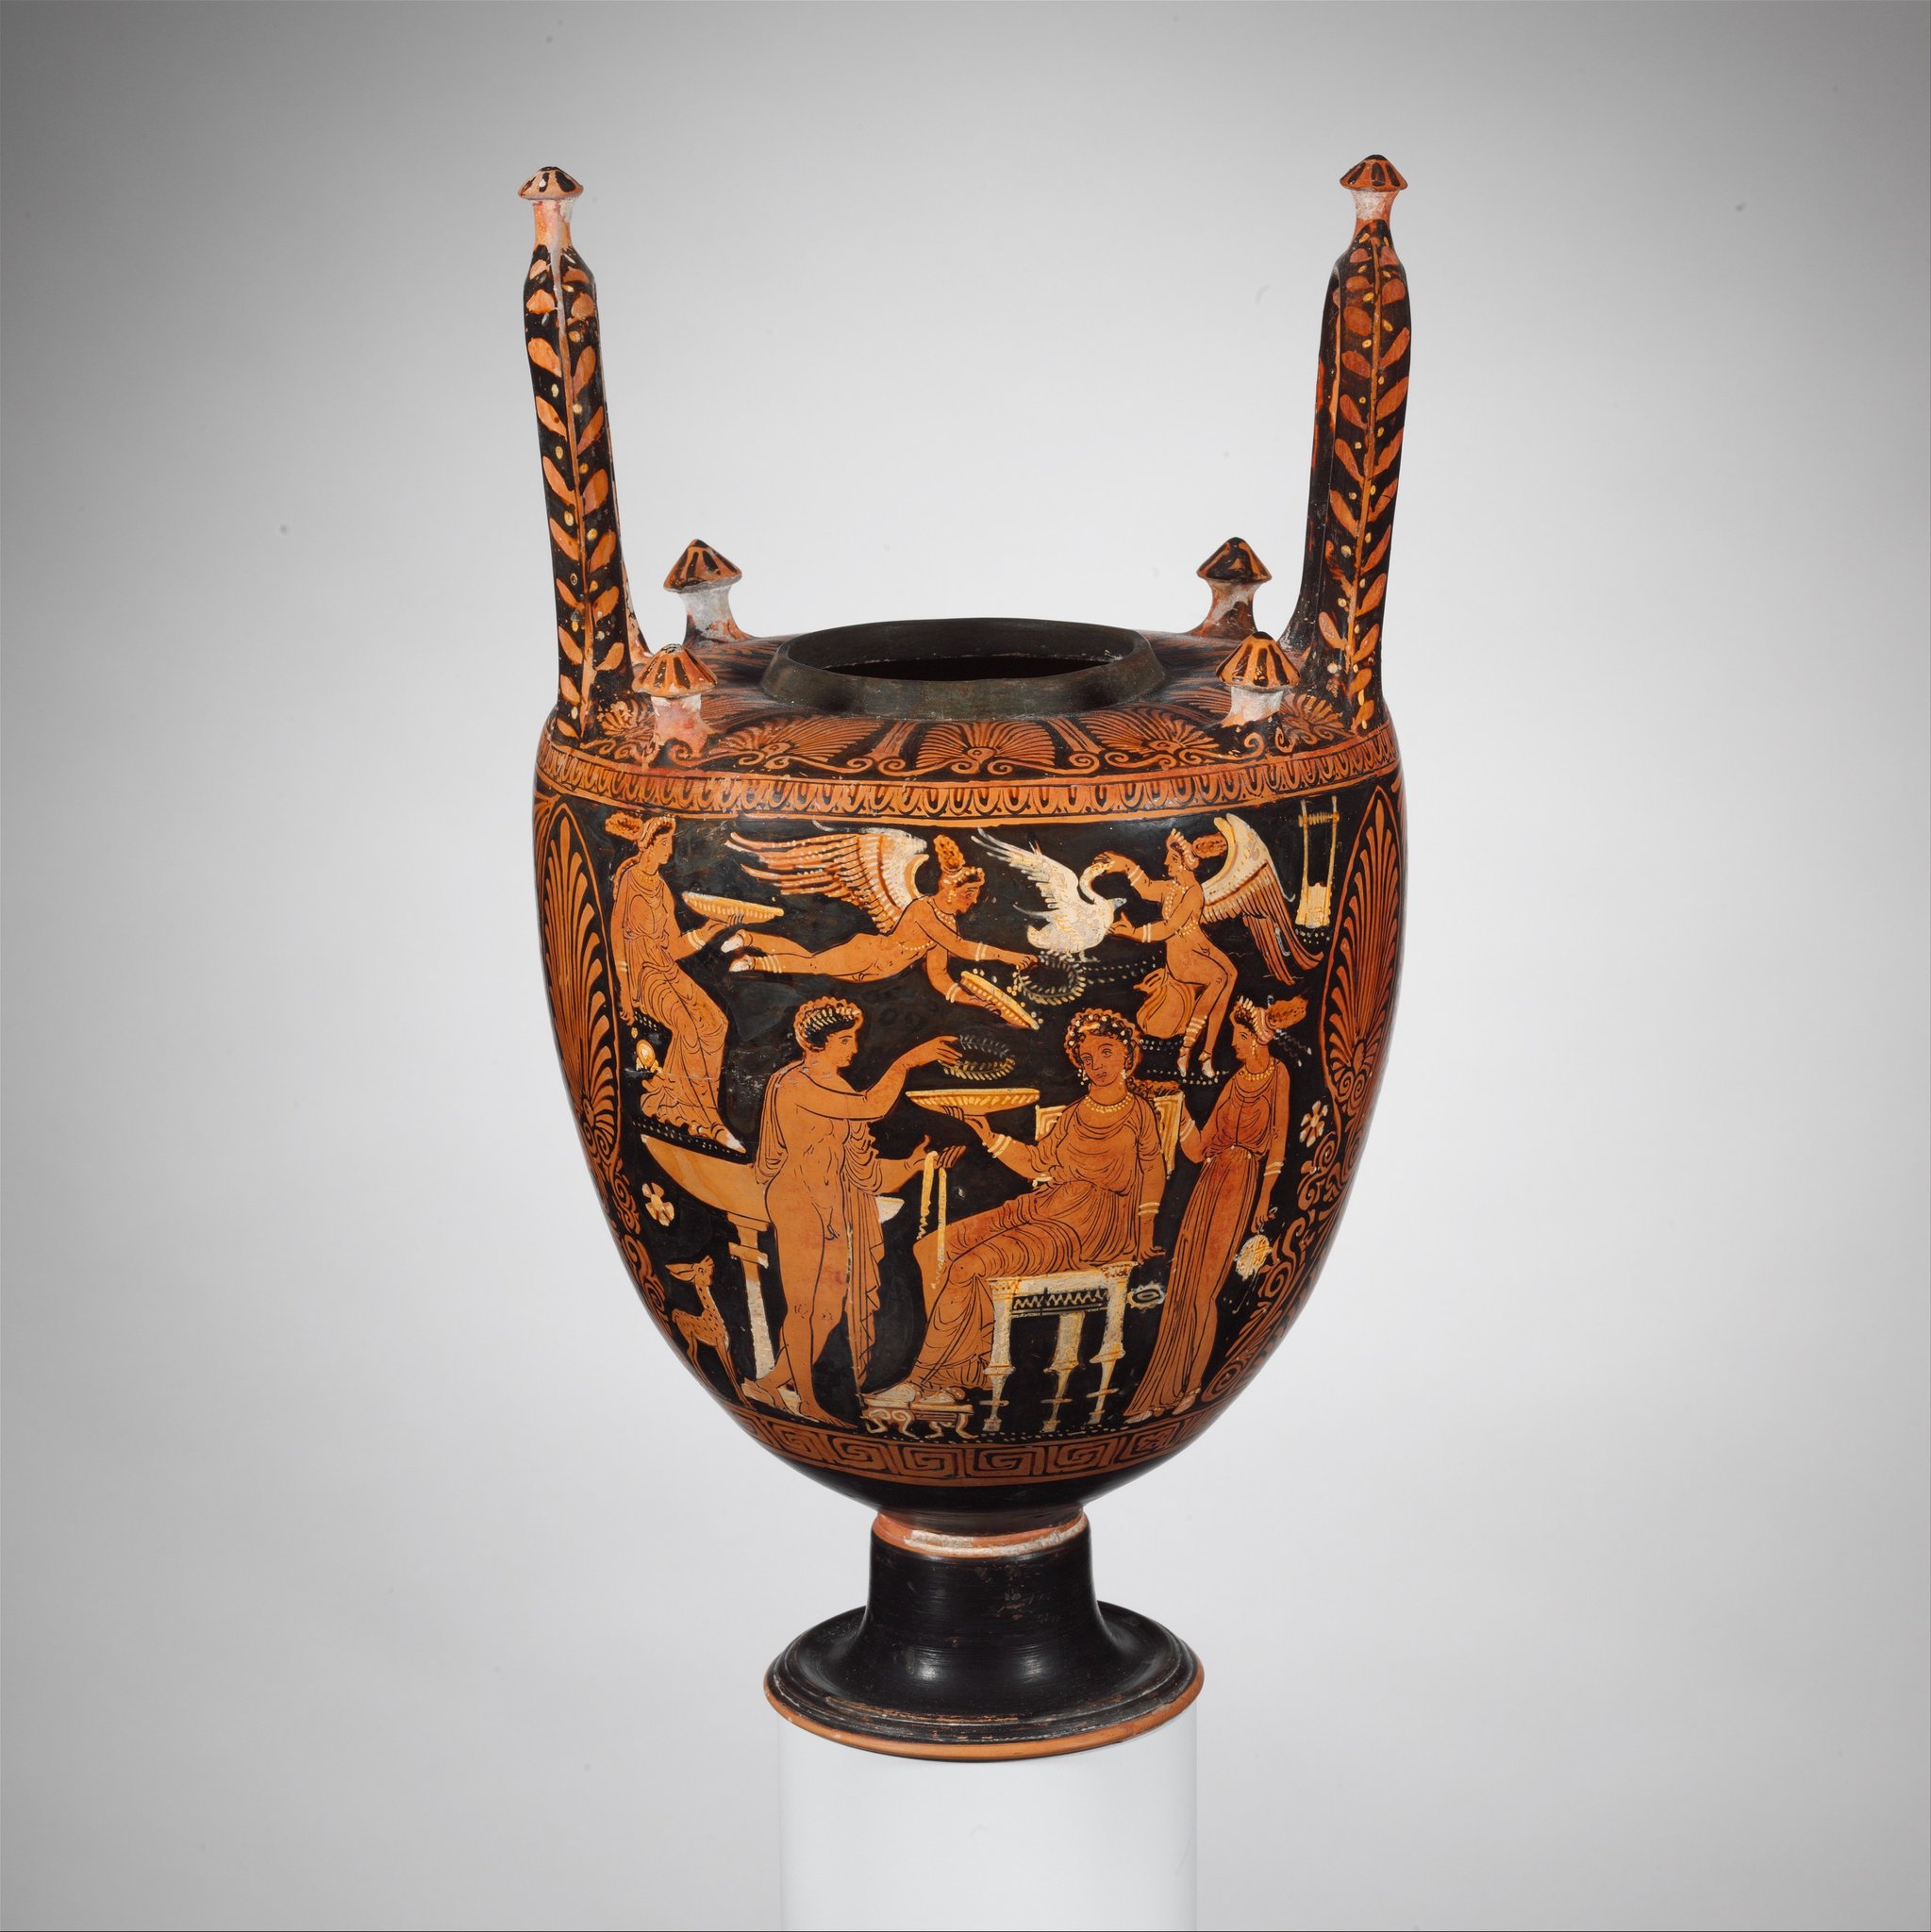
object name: lebes gamikos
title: Terracotta lebes gamikos (jar with lid, foot, and handles associated with weddings)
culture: greek, south italian, apulian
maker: group of new york 28.57.10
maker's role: artist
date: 340-320 BCE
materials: terracotta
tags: birds,palmettes,male nudes,women,eros,wreaths